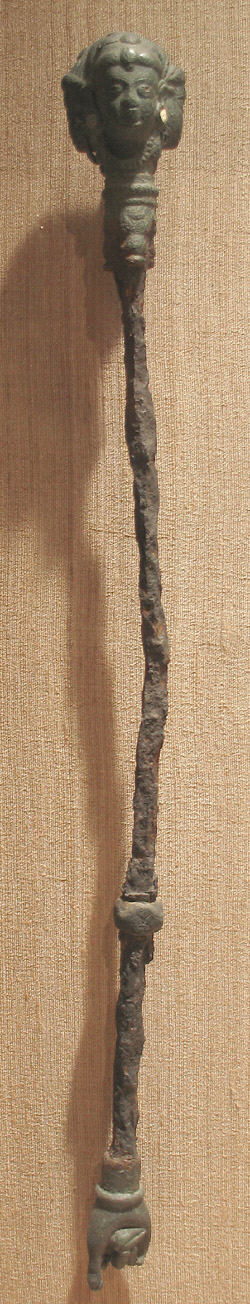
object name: scepter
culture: indian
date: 601-700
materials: bronze, iron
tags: faces